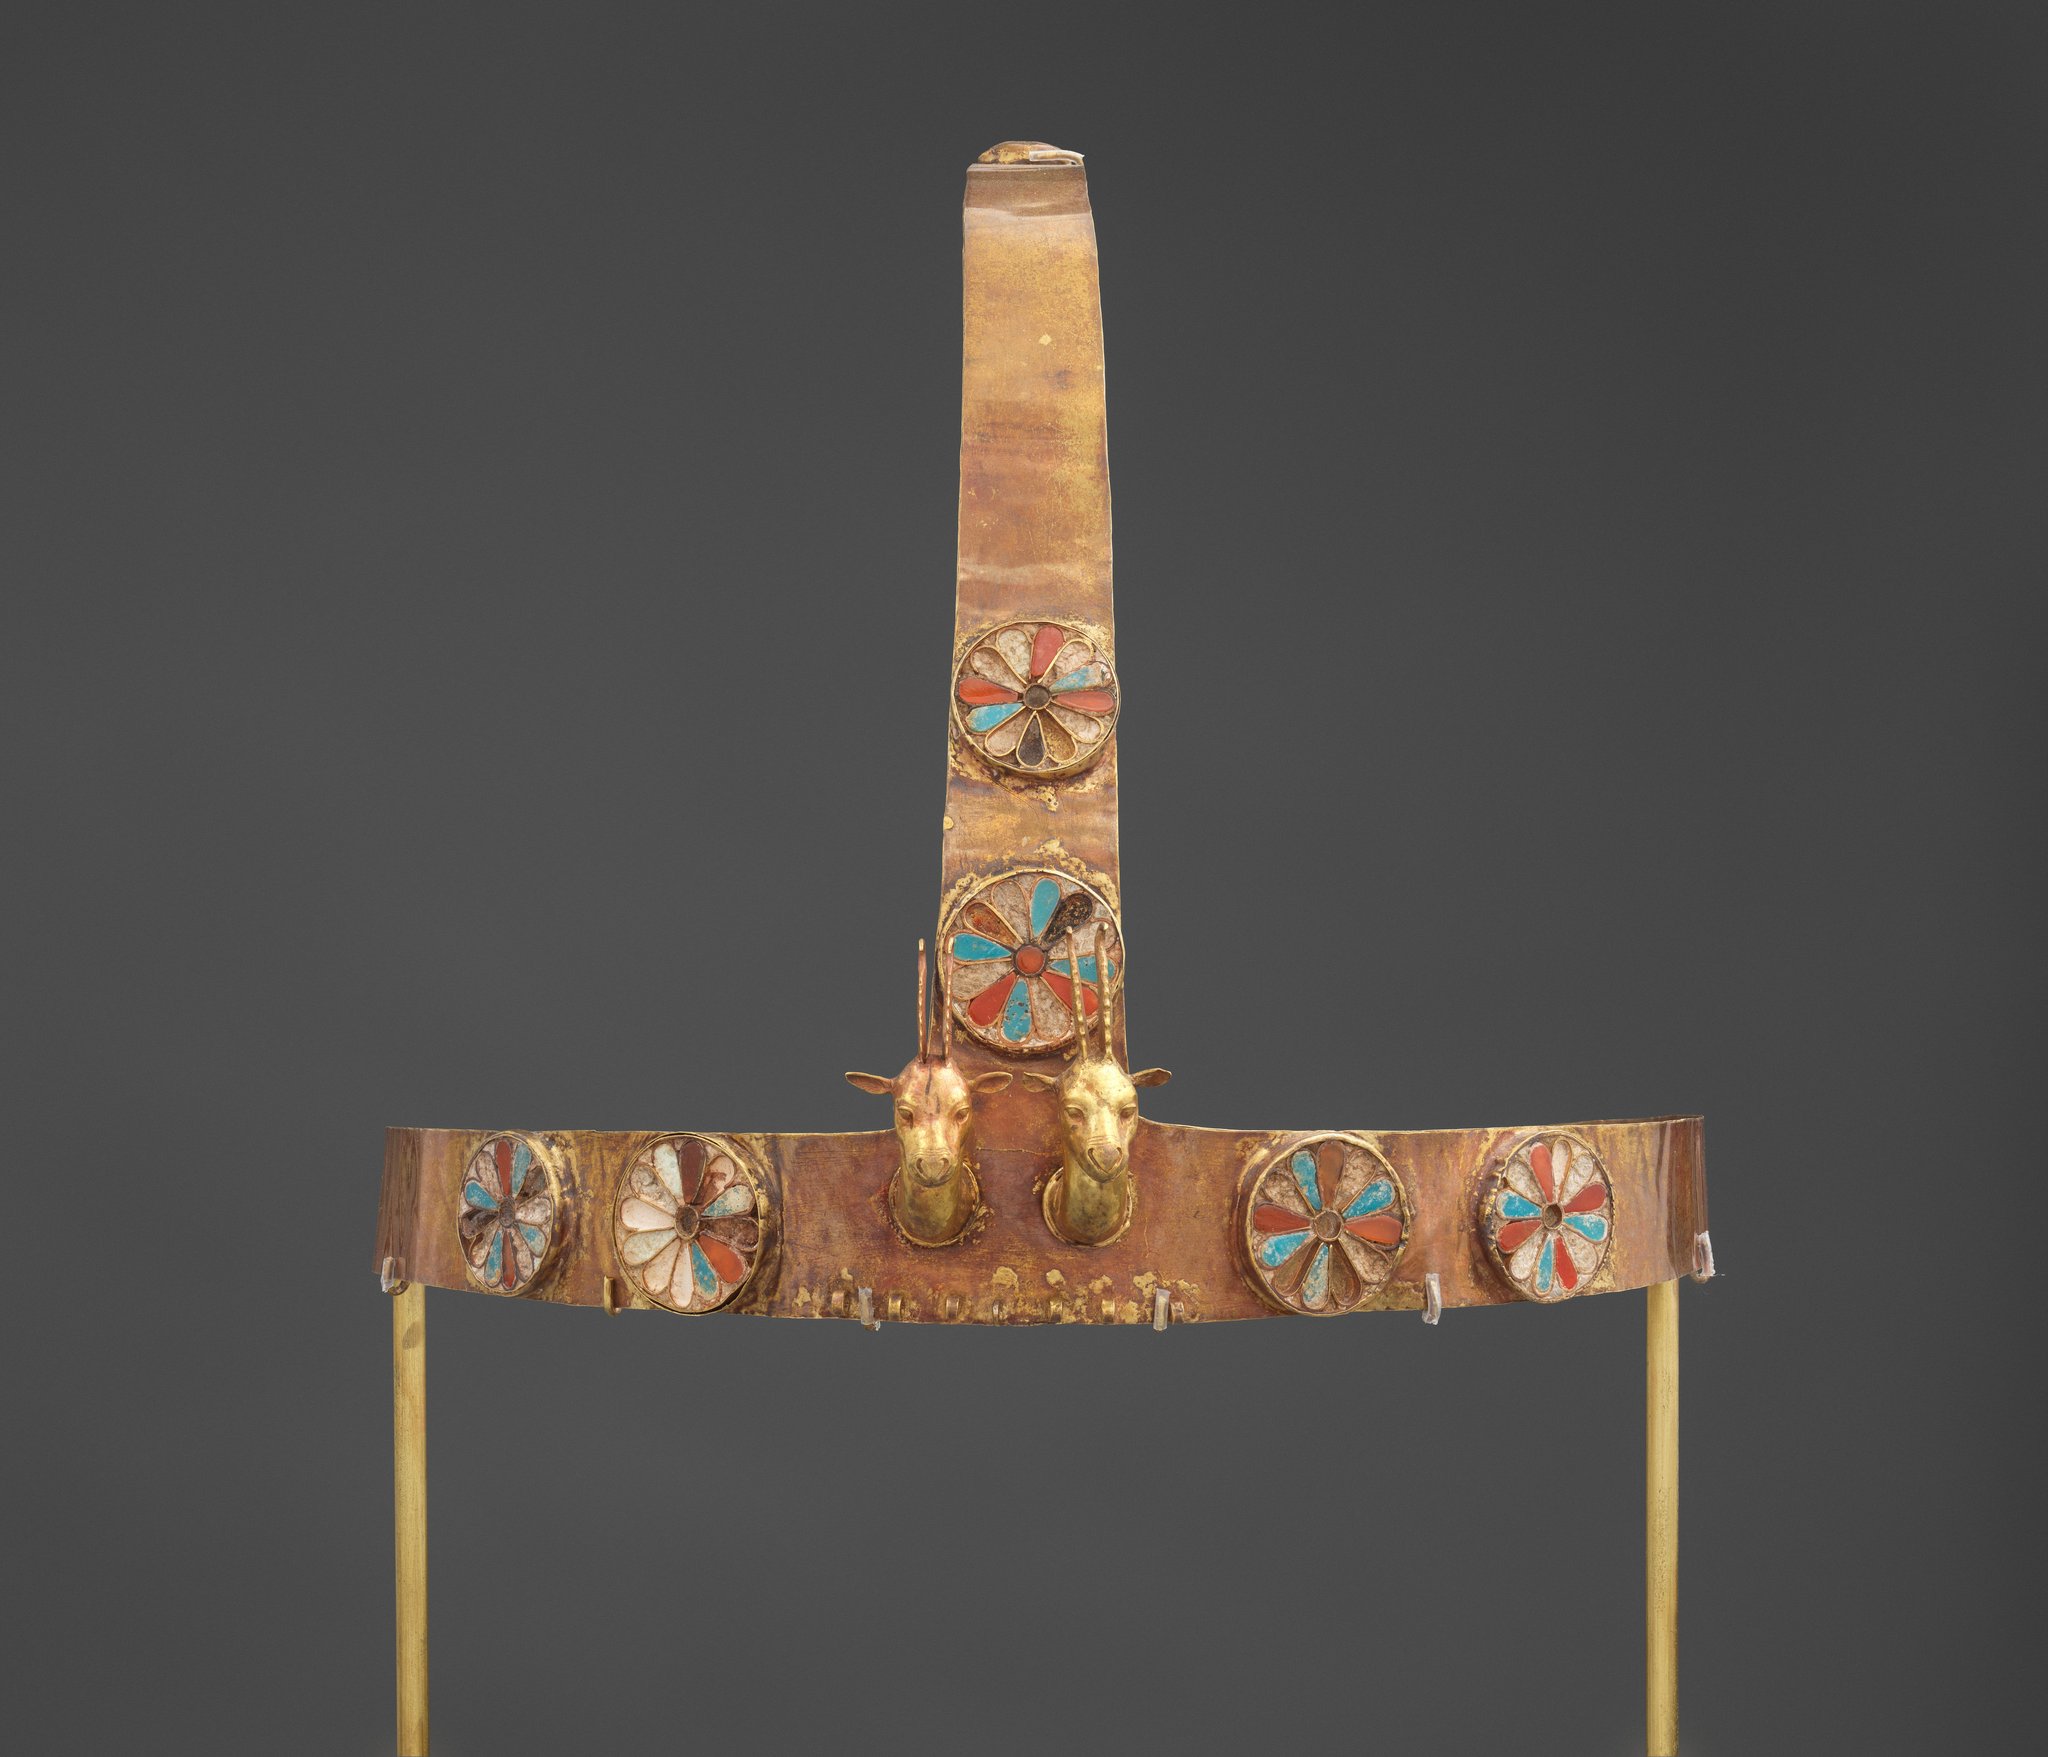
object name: diadem, two gazelle head in front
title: Diadem with a Pair of Gazelle Heads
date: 1479-1425 BCE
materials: gemstone, glass, gold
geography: egypt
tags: animals